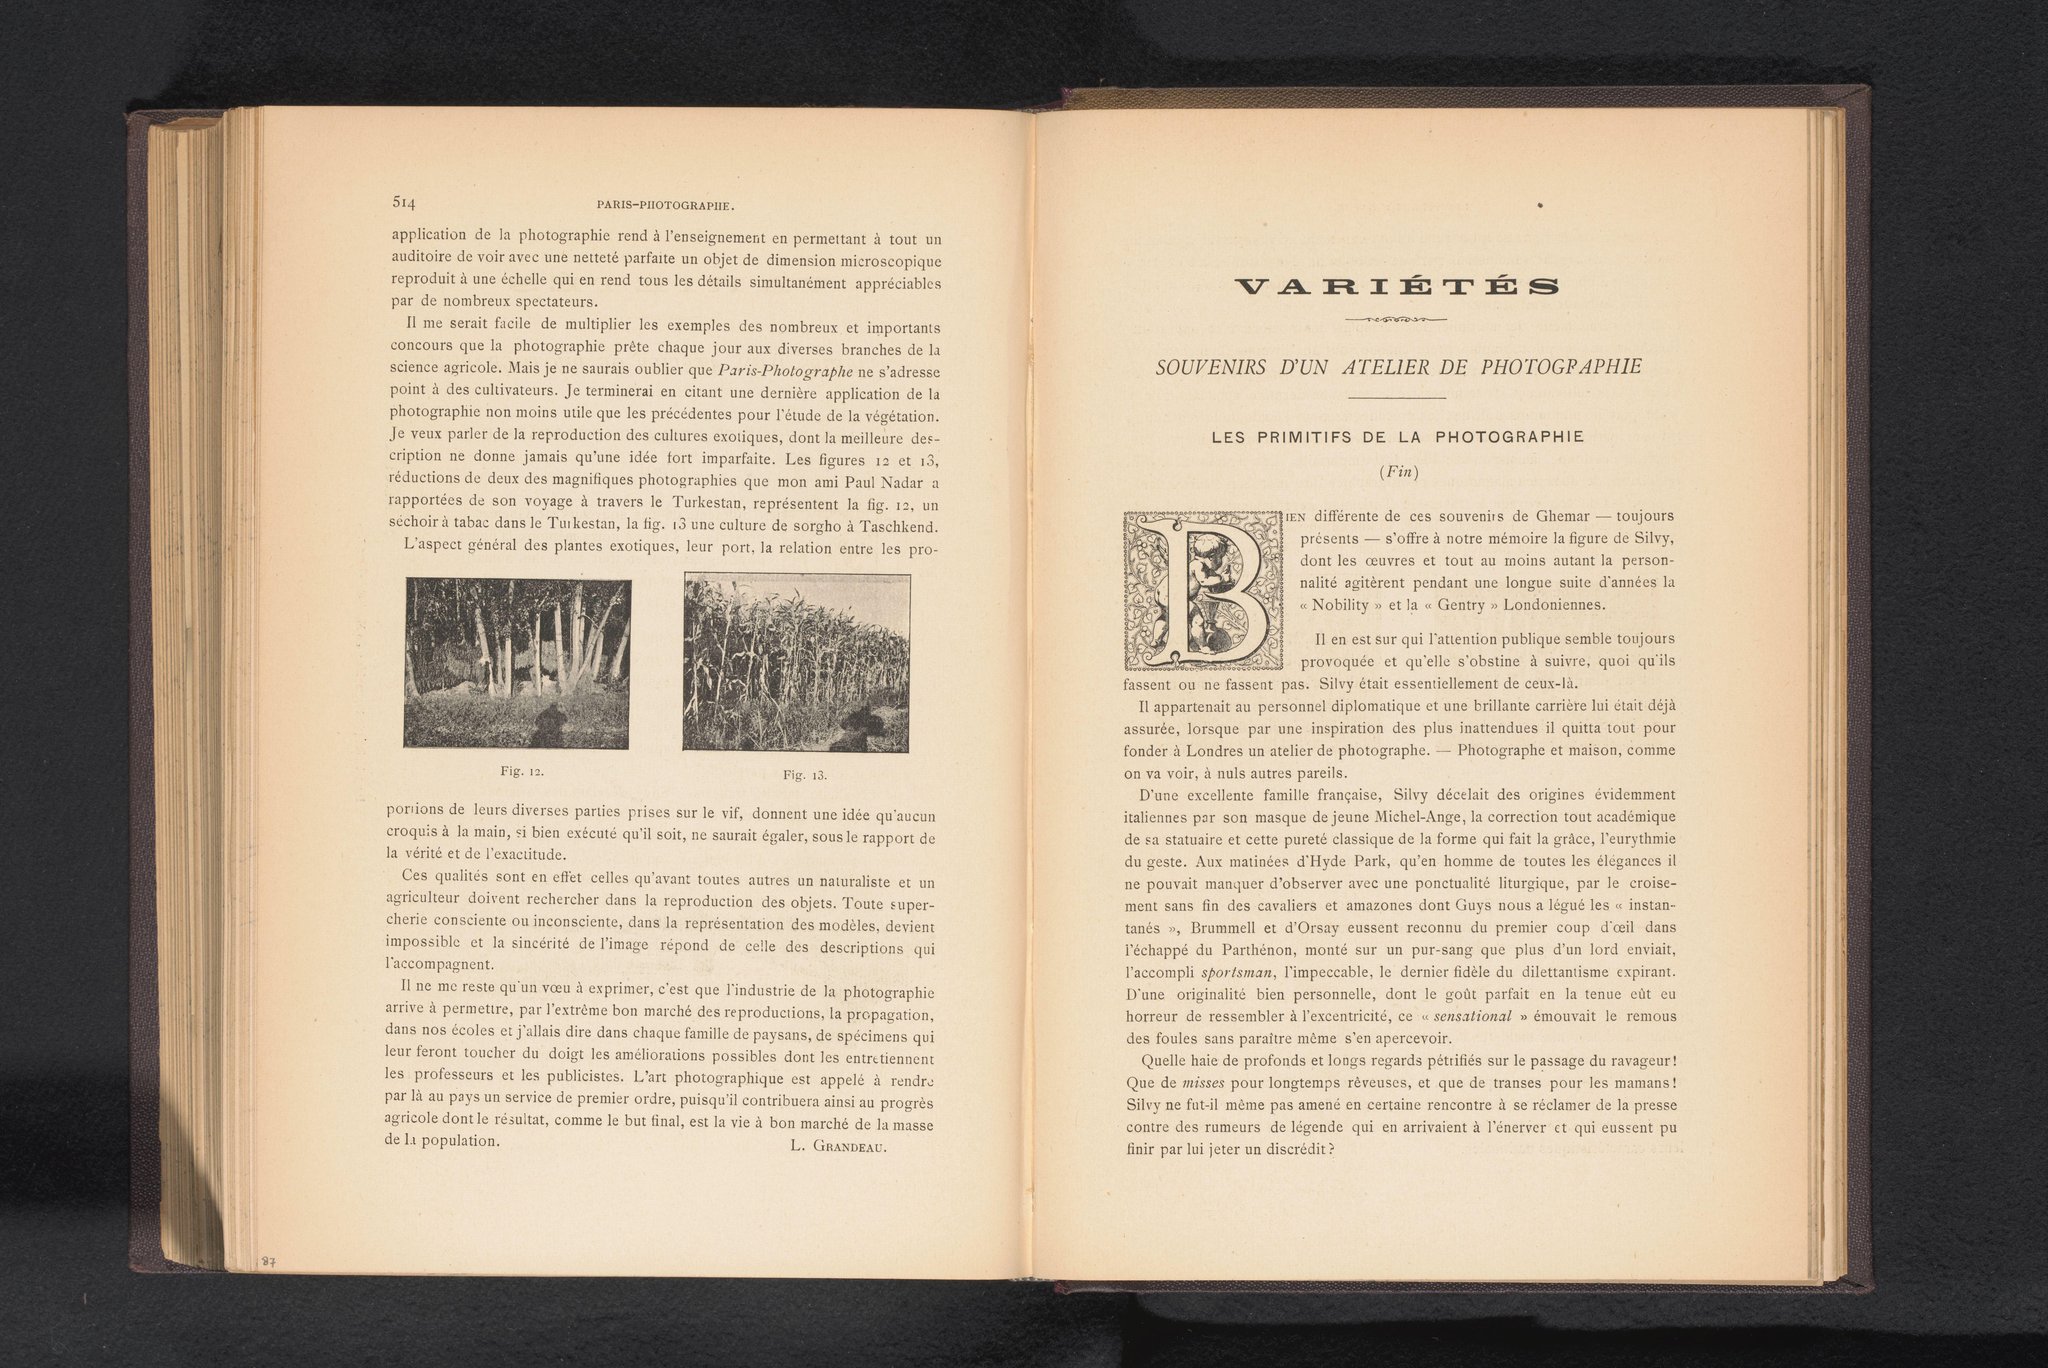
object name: photomechanical print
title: Akker met tabak en gierst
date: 1882-1892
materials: paper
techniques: autotype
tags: plants ~ agriculture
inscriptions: number: ‘Fig. 12. Fig. 13.’